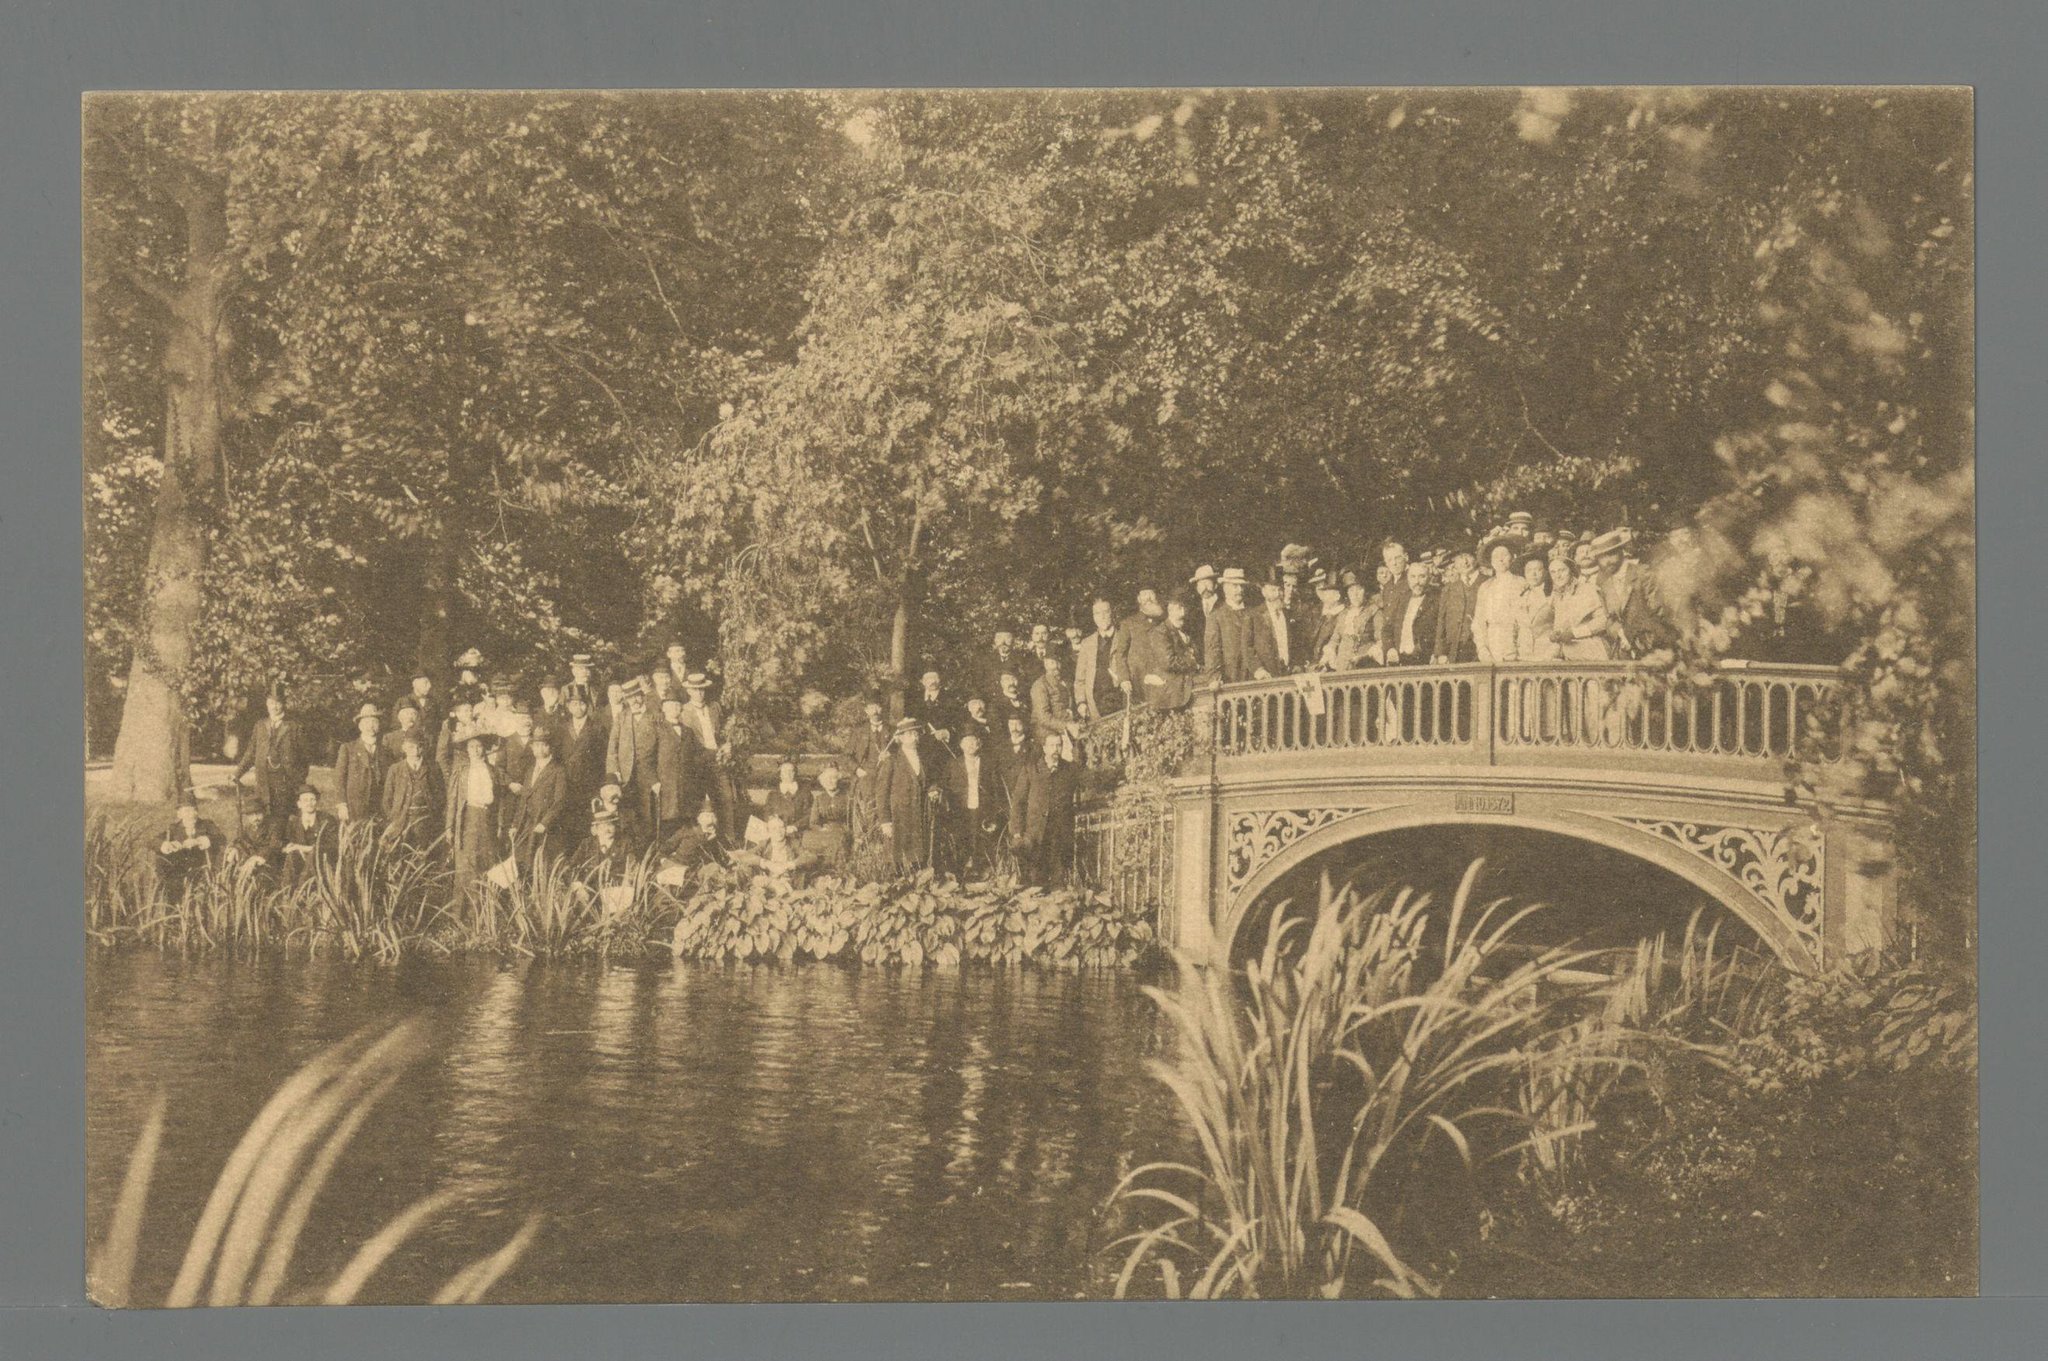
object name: photomechanical print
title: Het Groene Kruis-Congres in het park van H. M. de Koningin-Moeder te Soestdijk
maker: Anonymous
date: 1910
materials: cardboard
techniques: photograph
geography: soestdijk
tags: park, canal, bridge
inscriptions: date